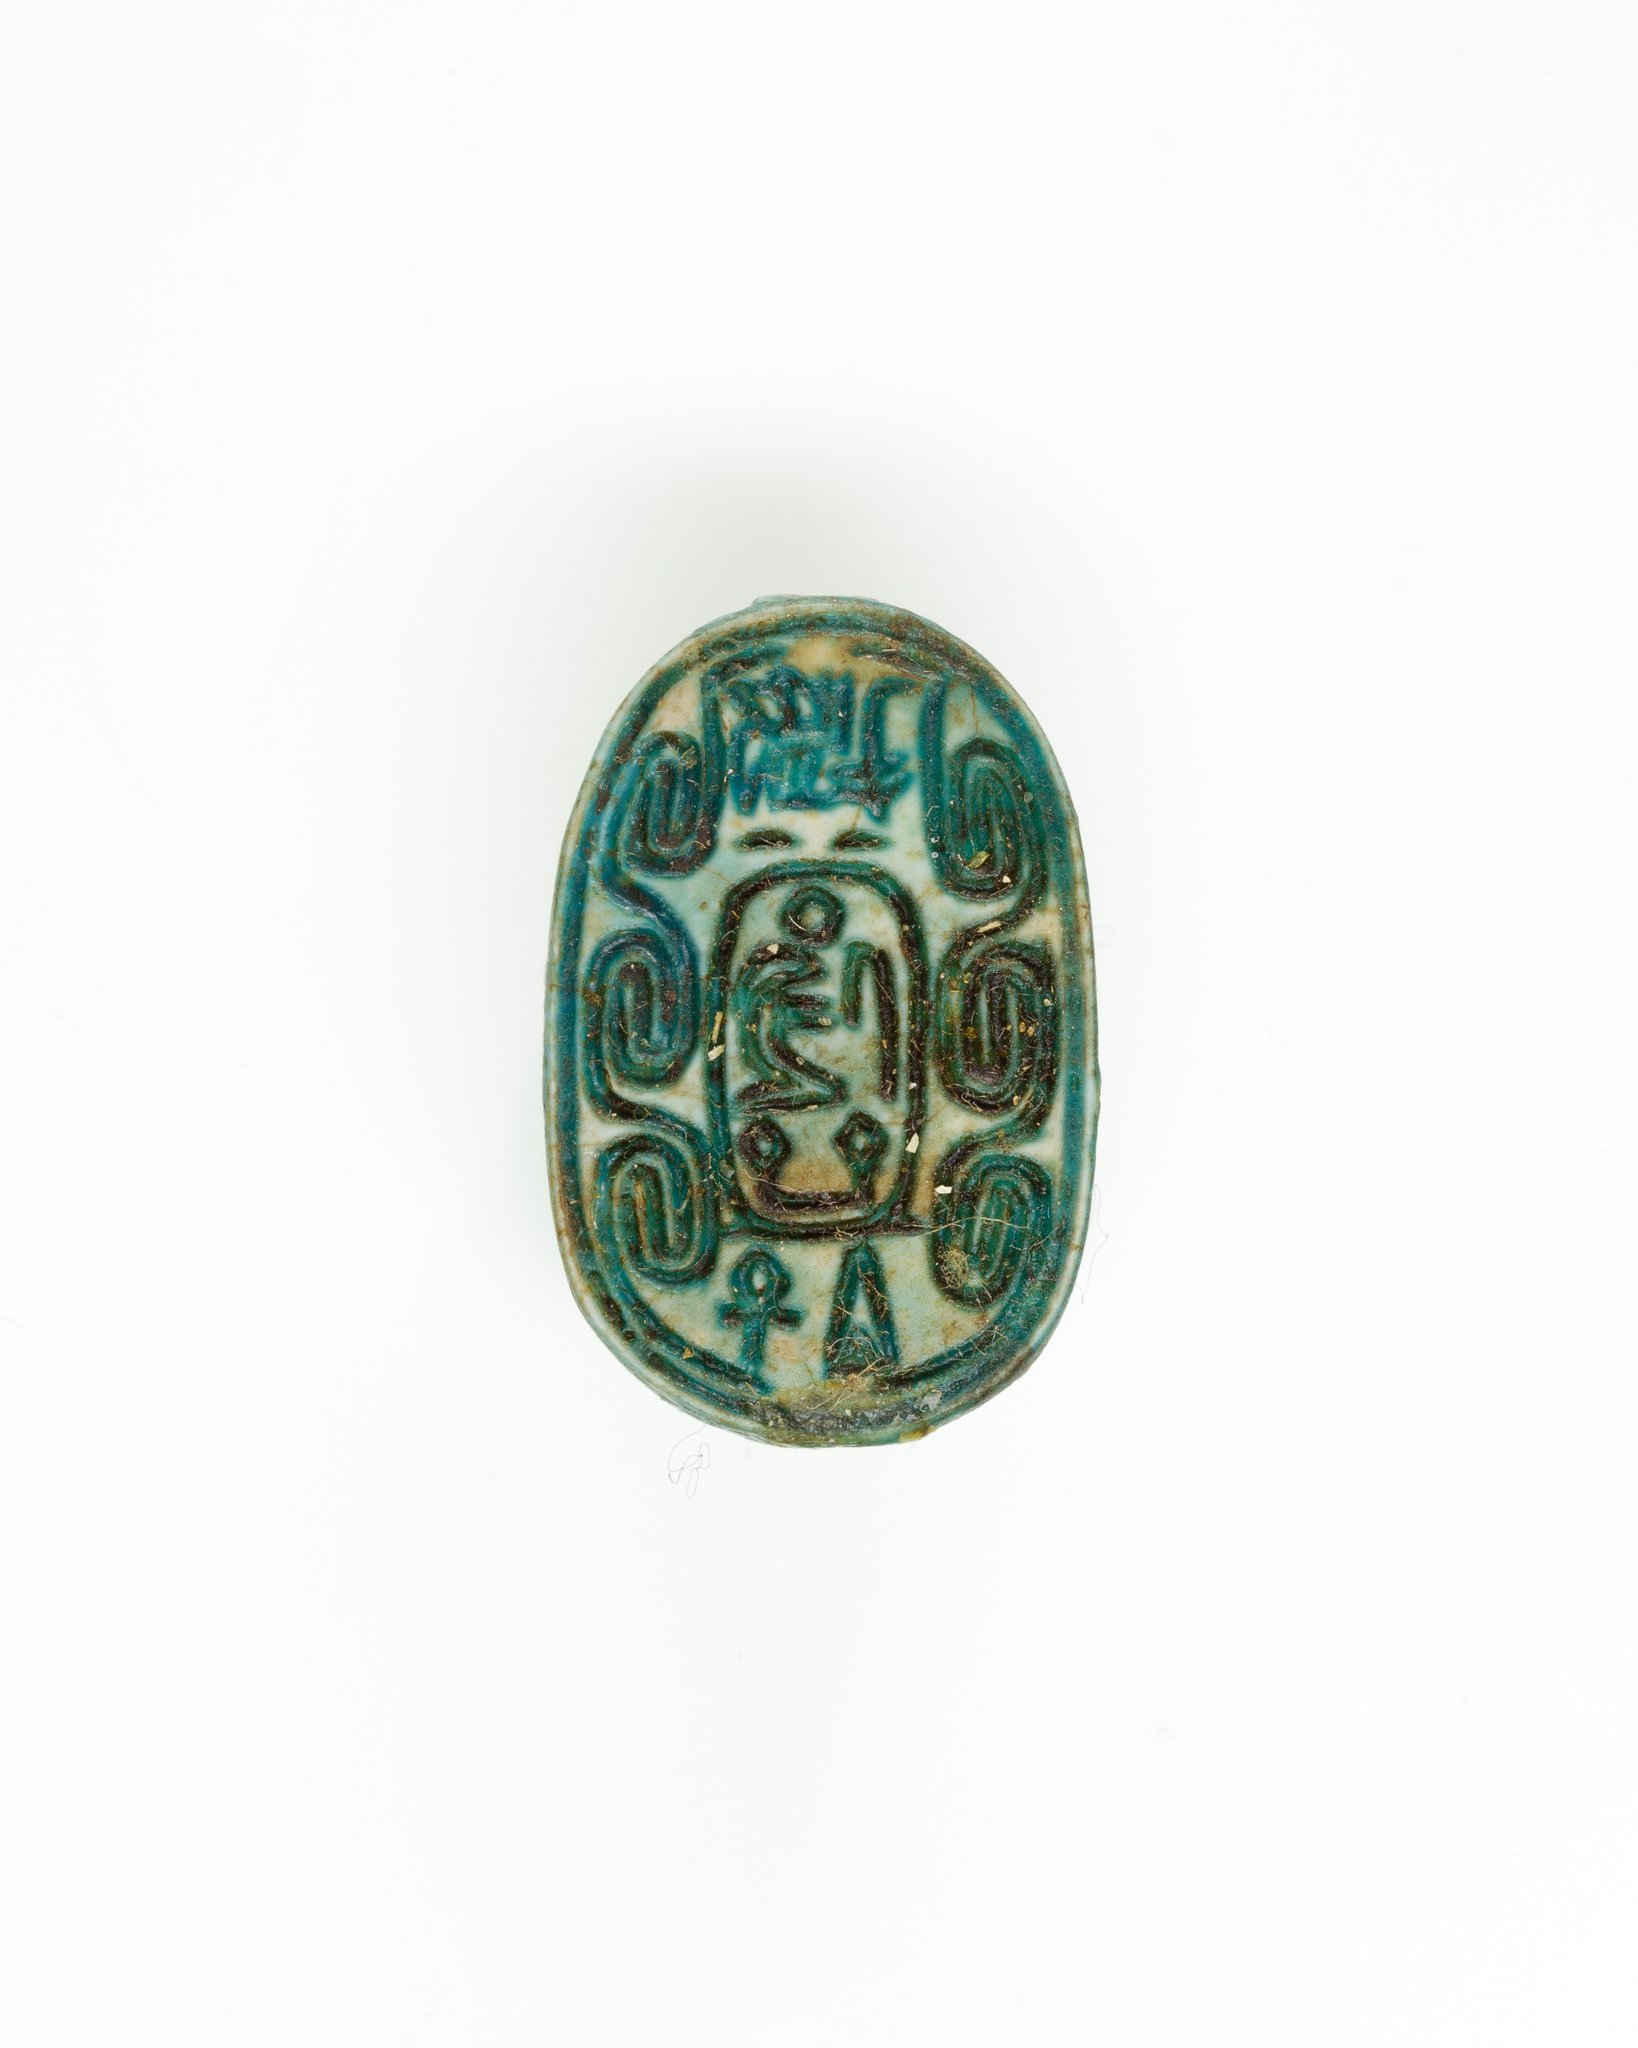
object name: scarab, sedjefakare, amenemhat vii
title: Scarab With Throne Name of Amenemhat VII (Sedjefakare)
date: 1768-1765 BCE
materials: stone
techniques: glazing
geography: egypt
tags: scarabs